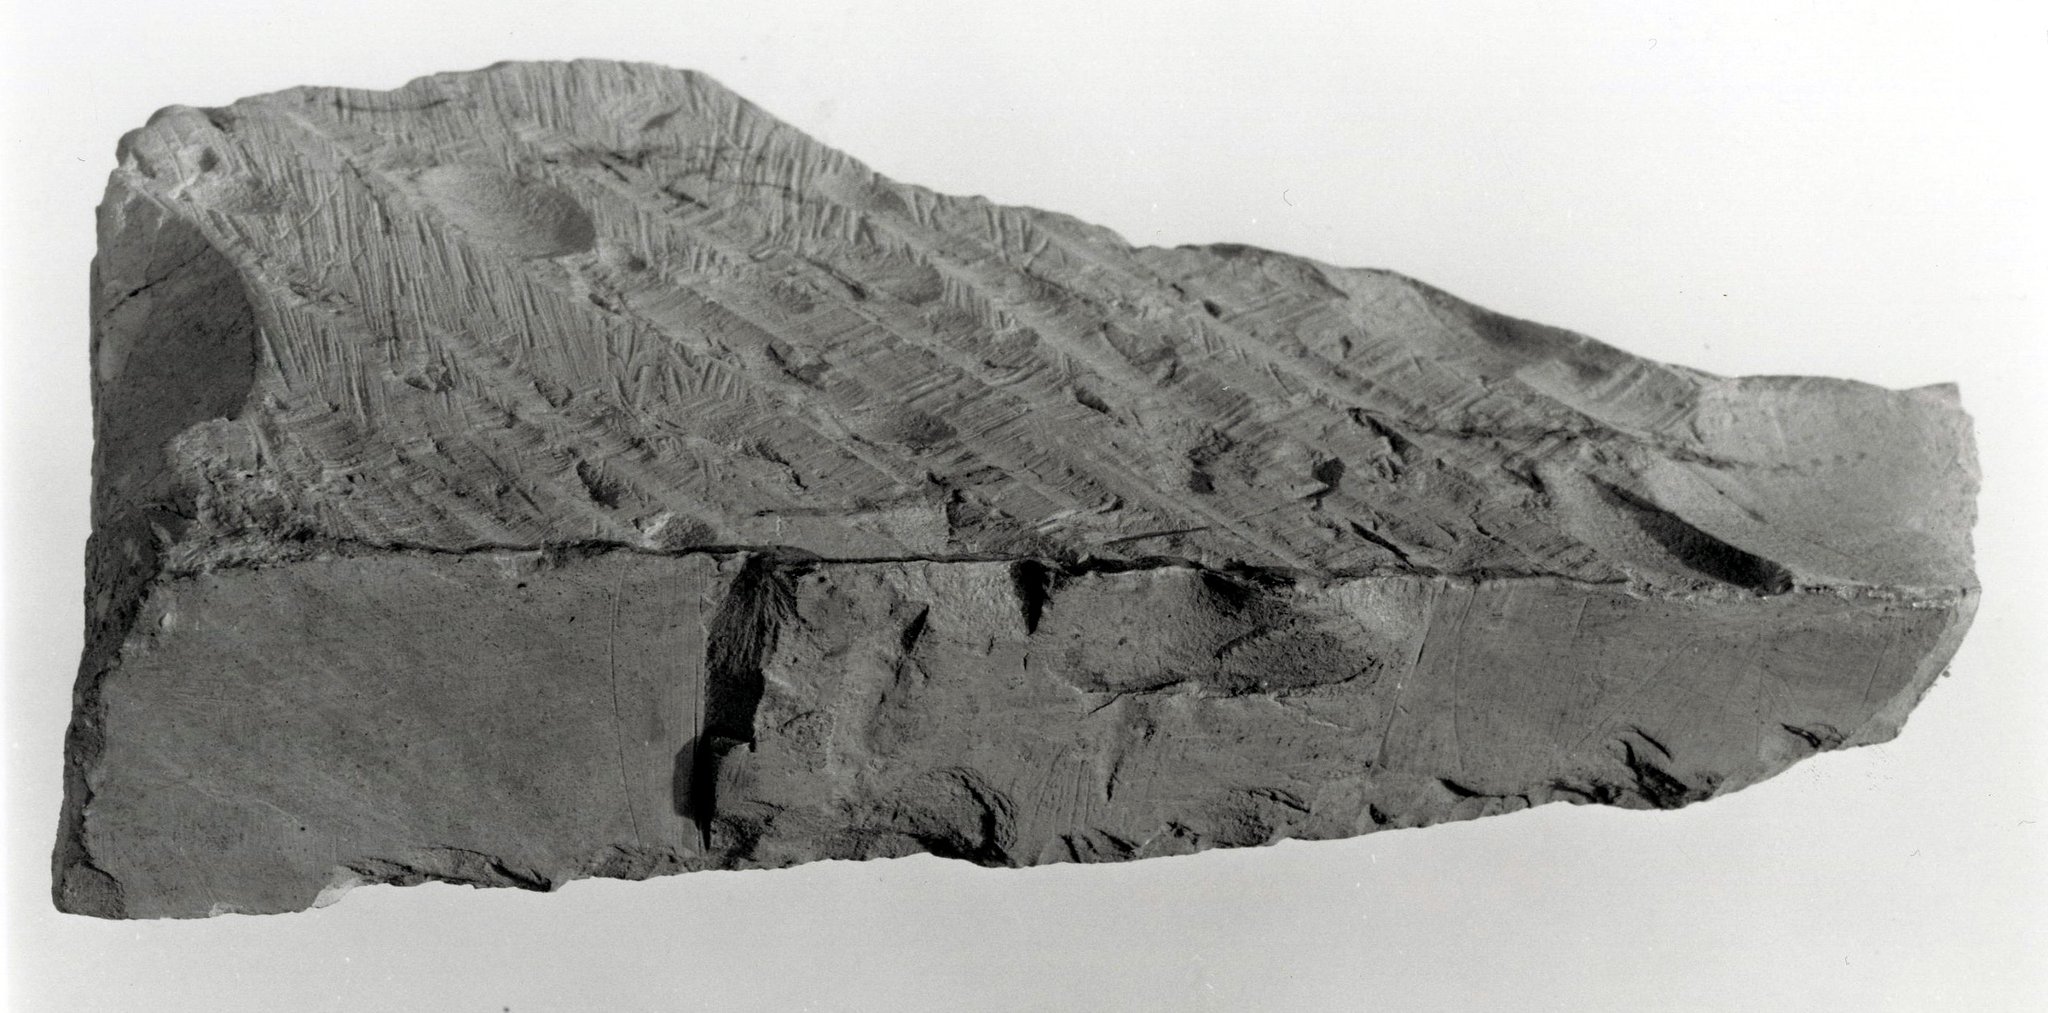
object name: relief, tomb of nespekashuty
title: Raised relief fragment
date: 664-610 BCE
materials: limestone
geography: egypt